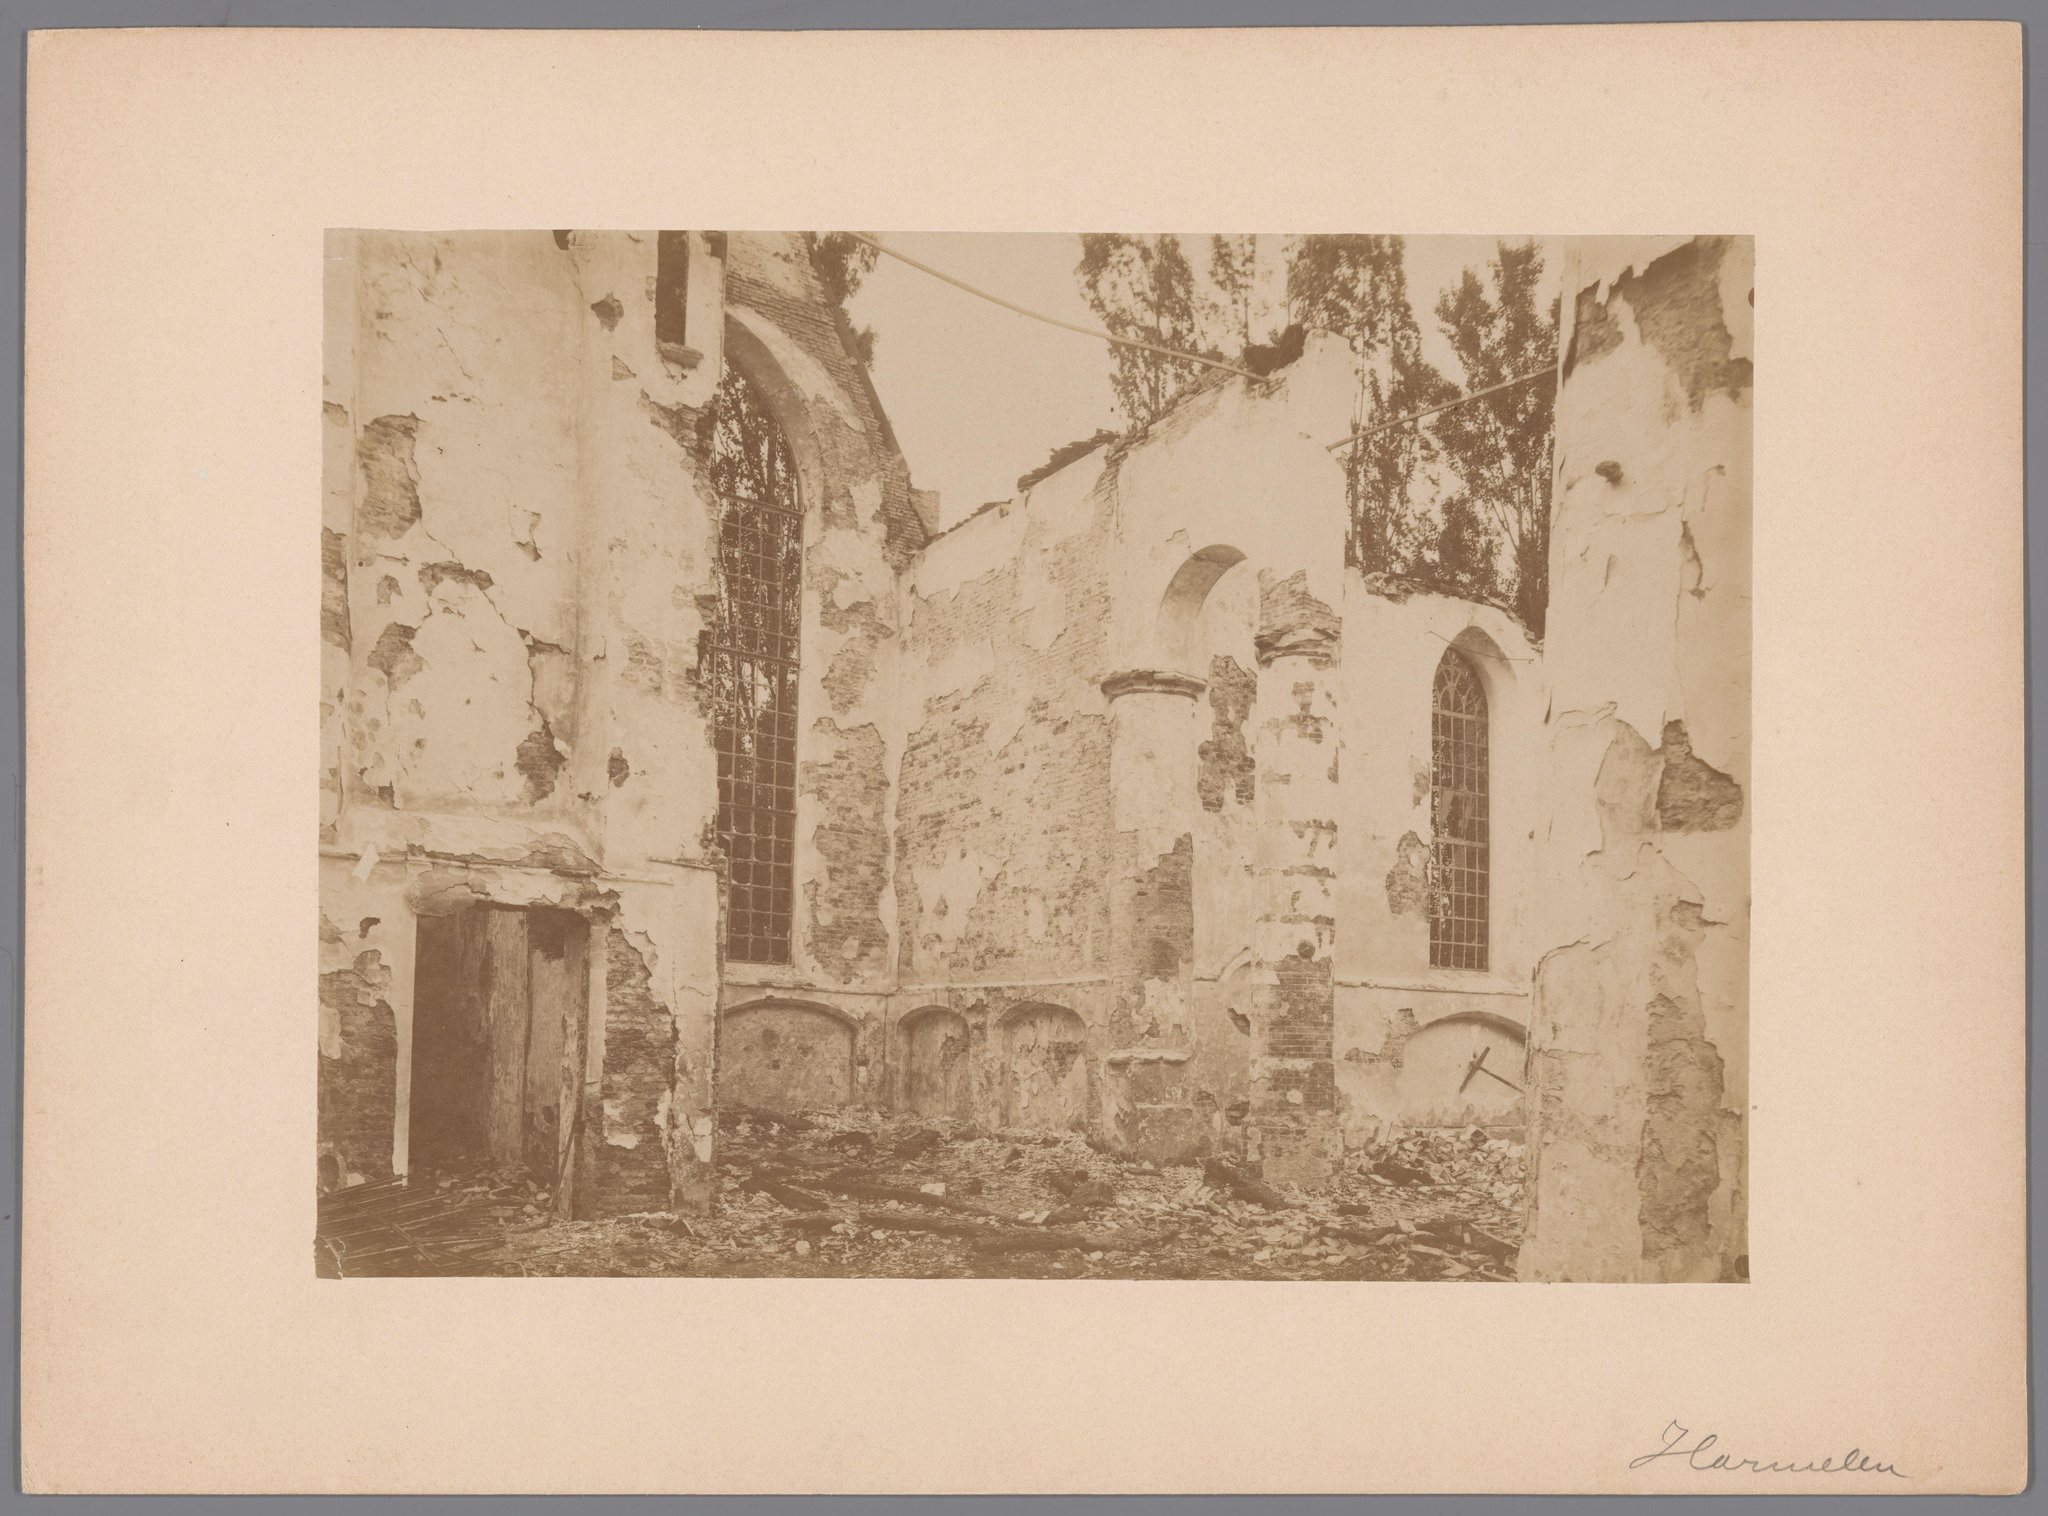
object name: photograph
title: Interieur de afgebrande Hervormde Kerk te Harmelen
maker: anoniem (monumentenzorg)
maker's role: fotograaf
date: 1900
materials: cardboard, photographic support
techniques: albumen print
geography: harmelen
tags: interior of church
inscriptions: annotation: ‘Kerk der N.H. gemeente te Harmelen (U.0? na den brand in juni 1900/ gezien naar het zuider transept’, annotation: ‘Harmelen’